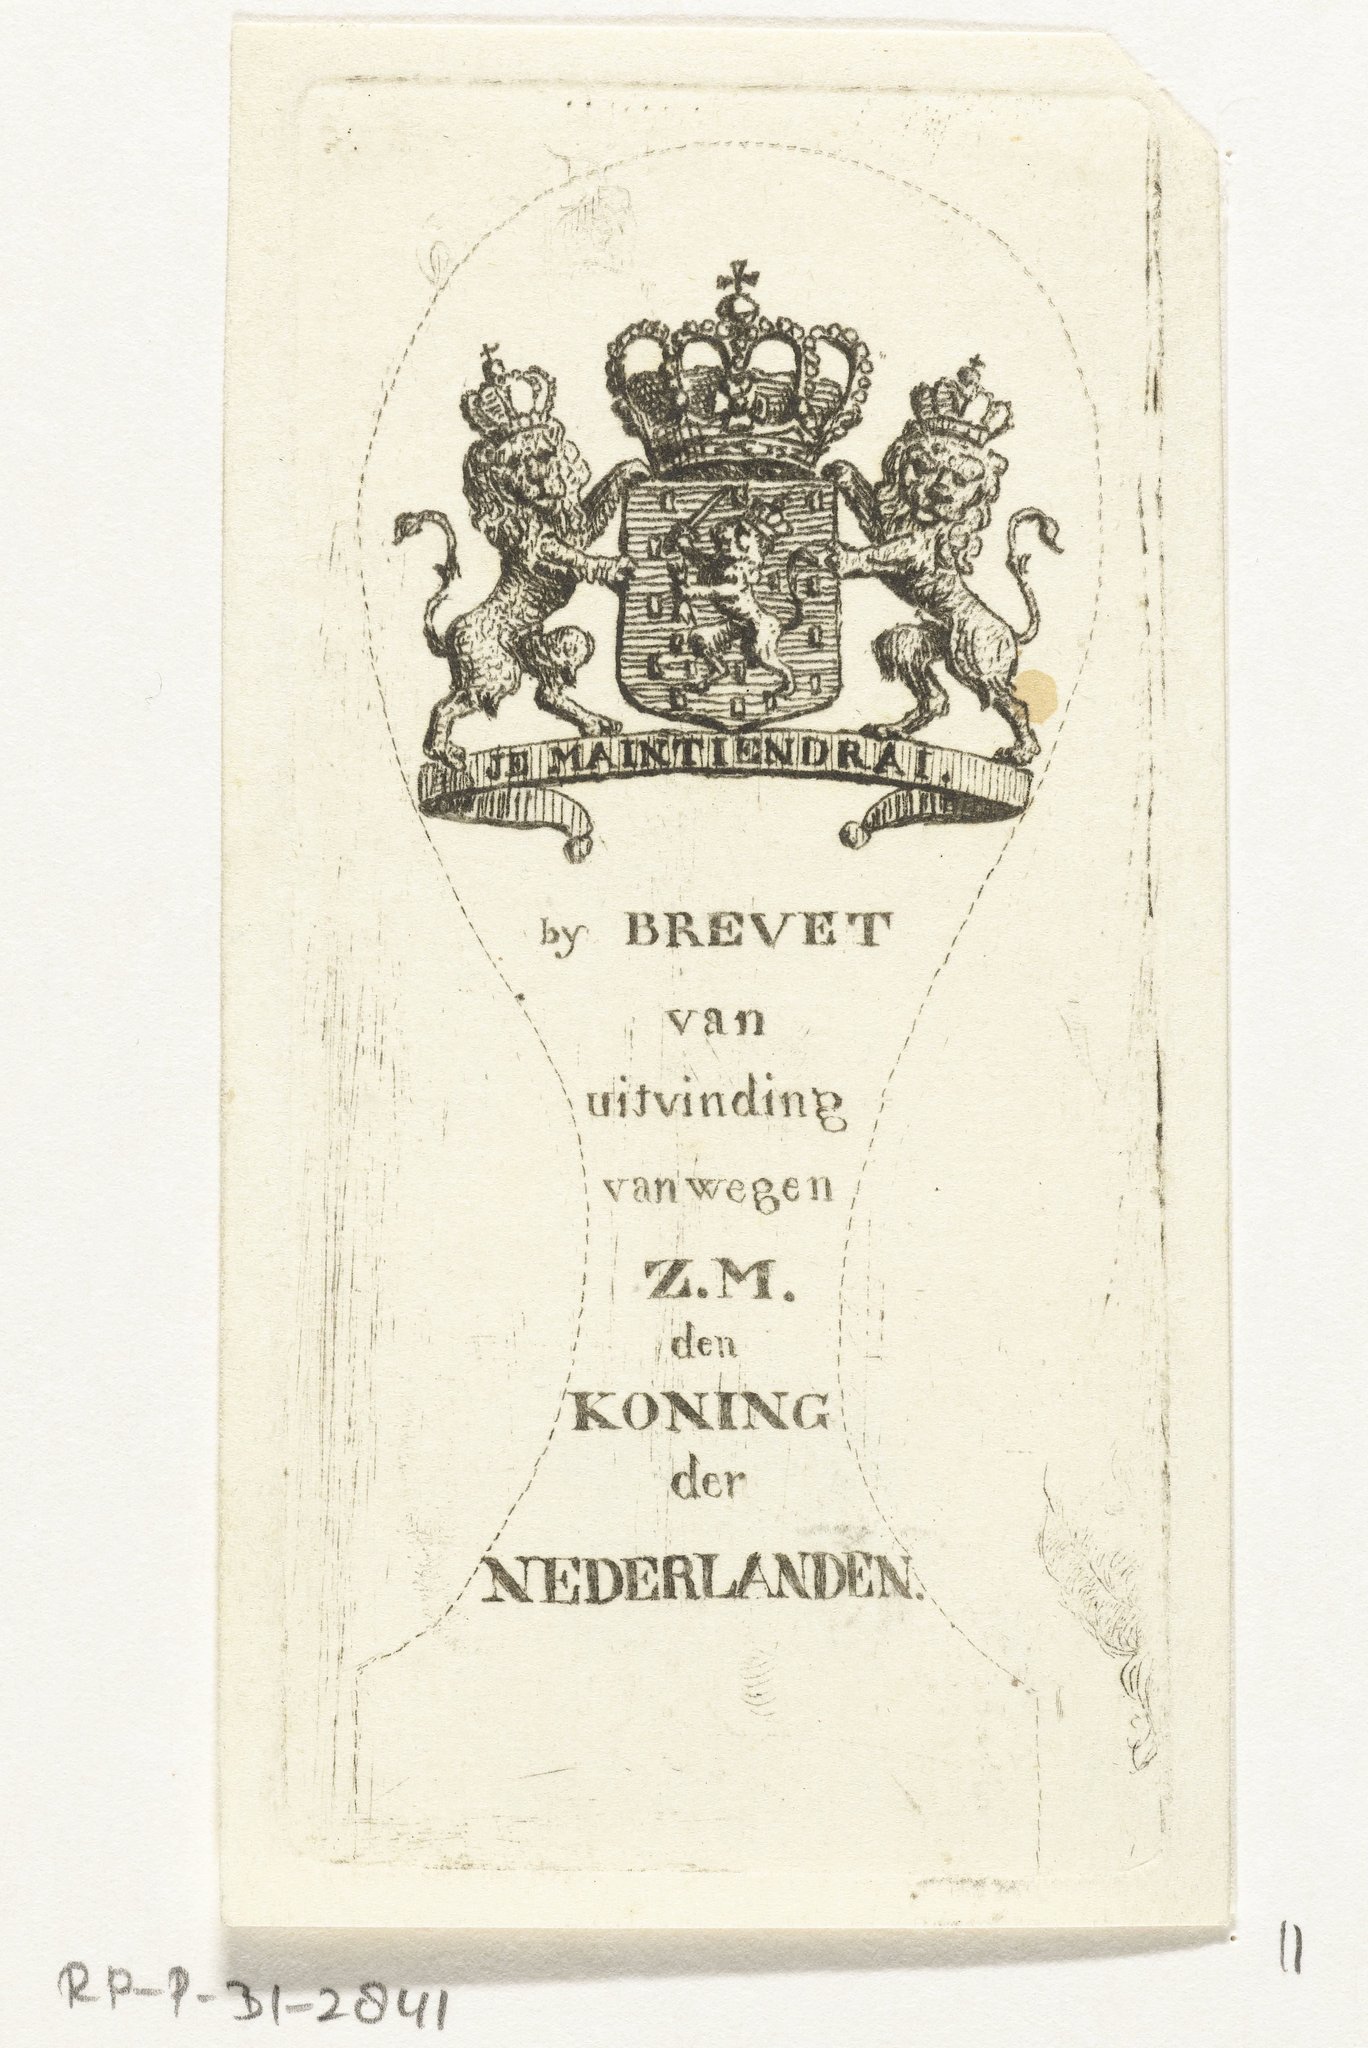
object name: print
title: Vignet met wapen van Nederland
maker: anthonie van den bos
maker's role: draughtsman, print maker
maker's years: 1763-1838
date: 1778-1838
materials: paper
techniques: etching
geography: netherlands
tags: armorial bearing, heraldry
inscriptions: collector's mark: Lugt 2228